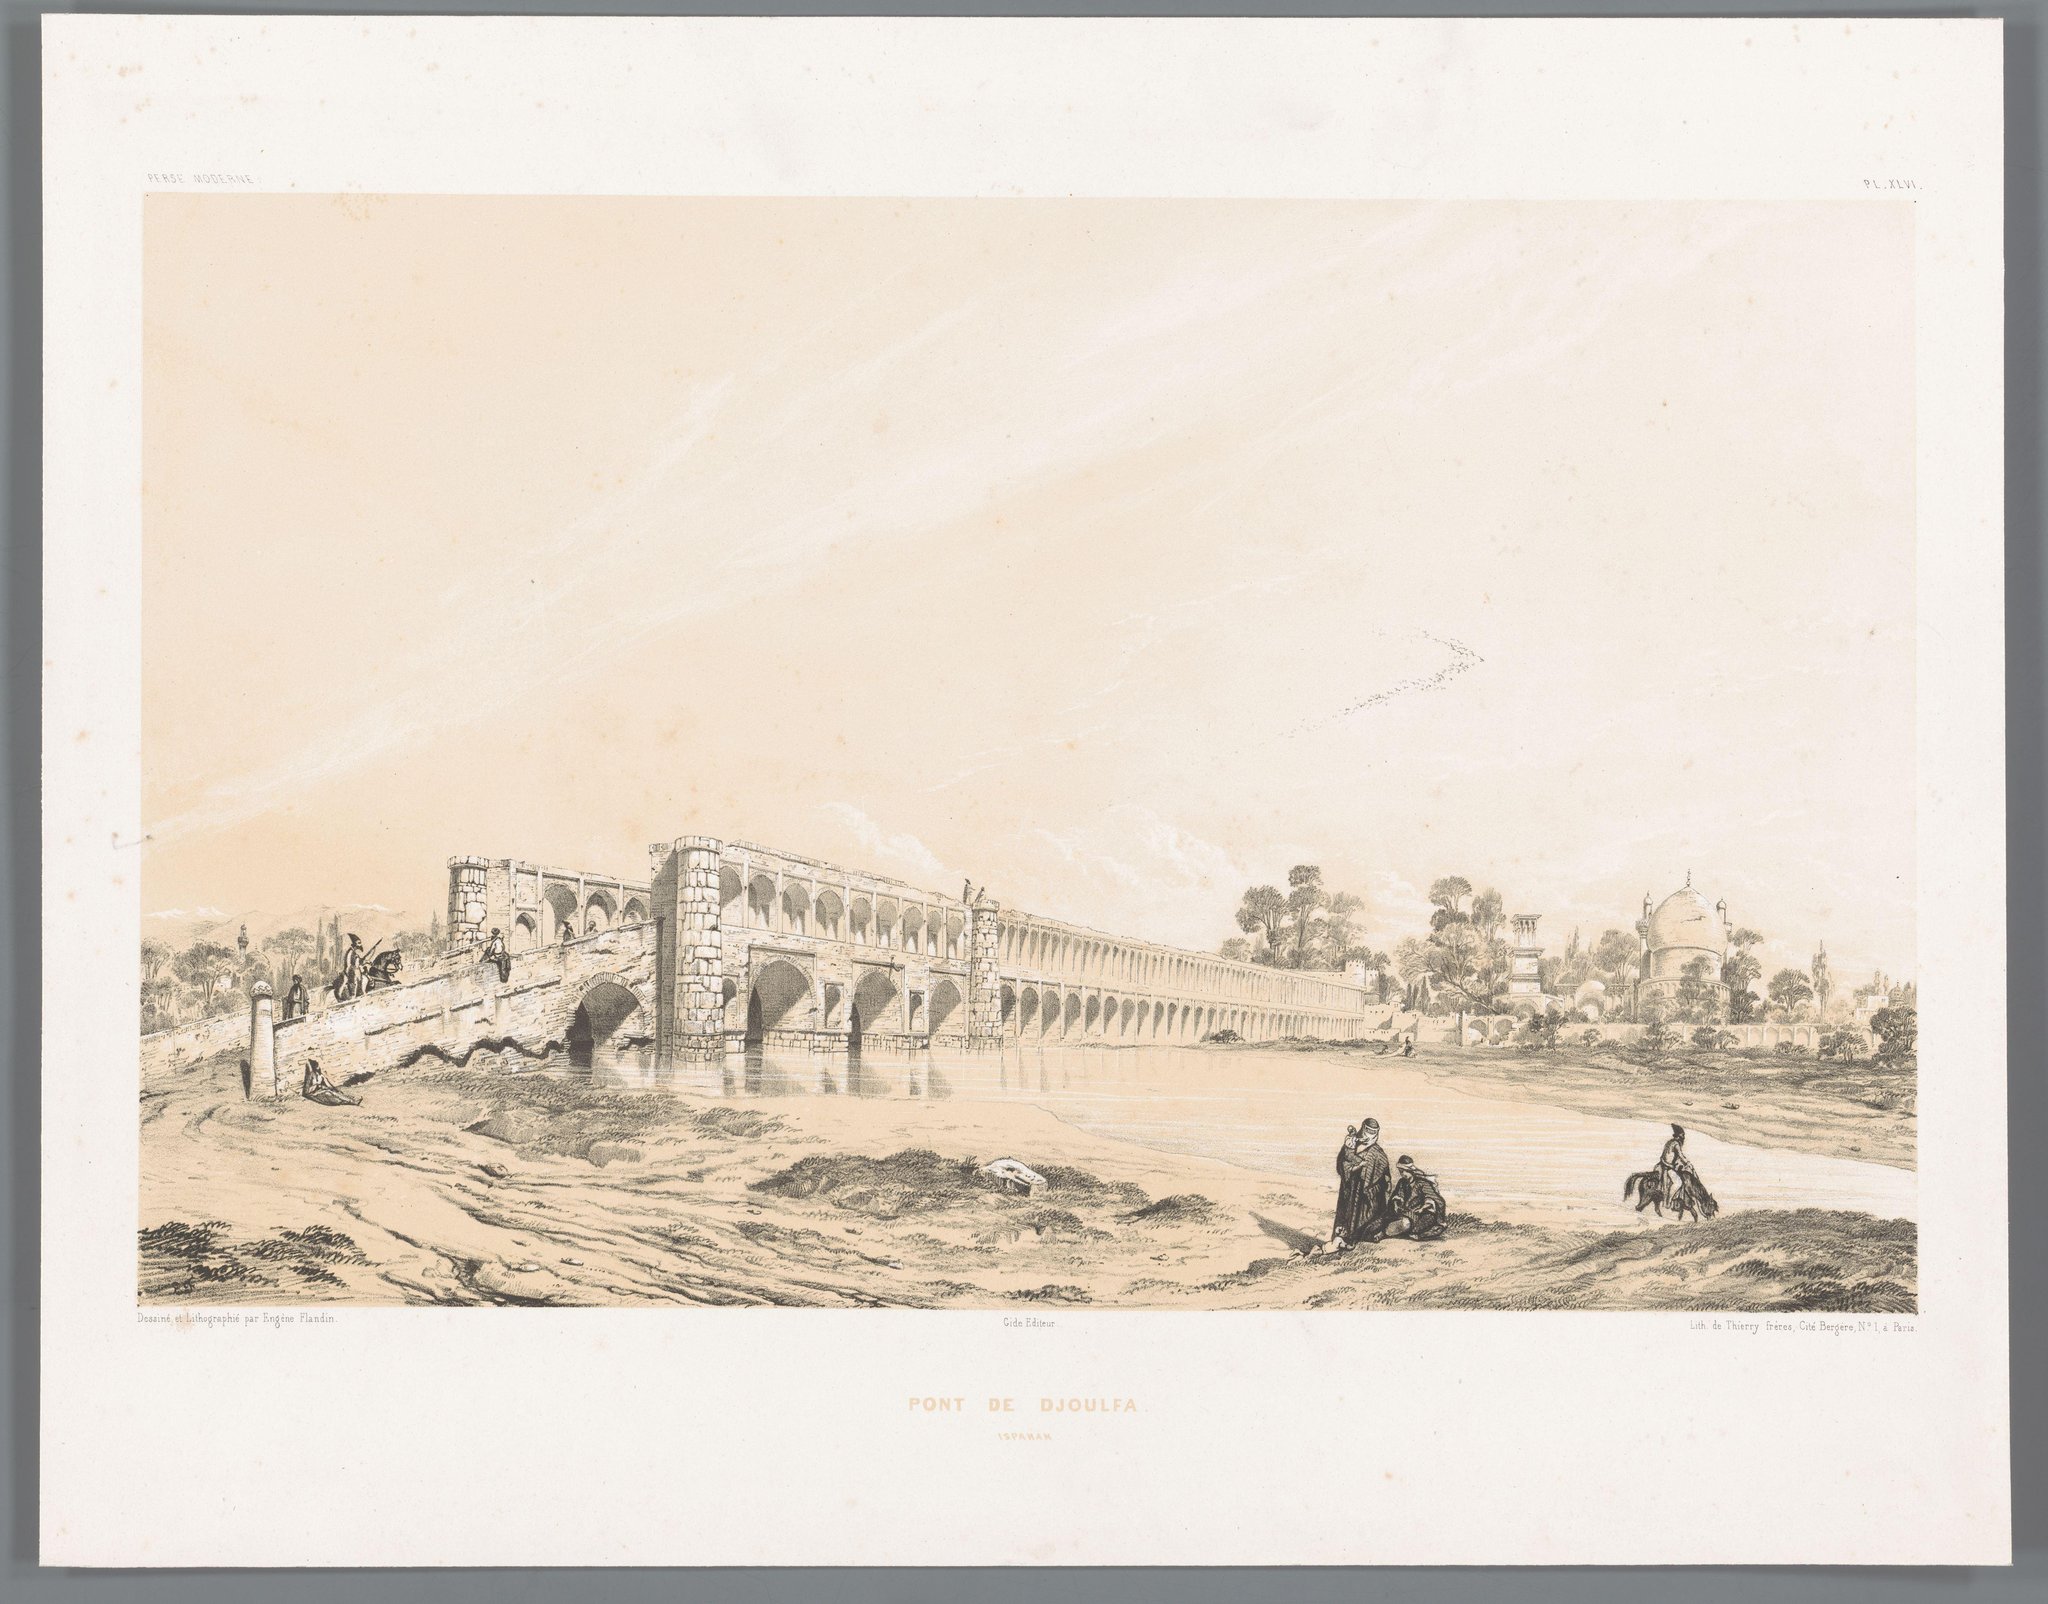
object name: book illustration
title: Perzische landschappen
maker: eugène flandin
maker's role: painter, print maker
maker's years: 1809-1889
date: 1843-1854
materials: paper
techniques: tone lithography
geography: paris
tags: bridge in city across river, canal, etc.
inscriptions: collector's mark: Lugt 2228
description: Prent uit: Coste, Pascal-Xavier en Eugène Napoléon Flandin. Voyage en Perse de mm. Eugène Flandin, peintre, et Pascal Coste, architecte (...). 8 dln. Parijs: Gide et Jules Baudry, 1843-1854.